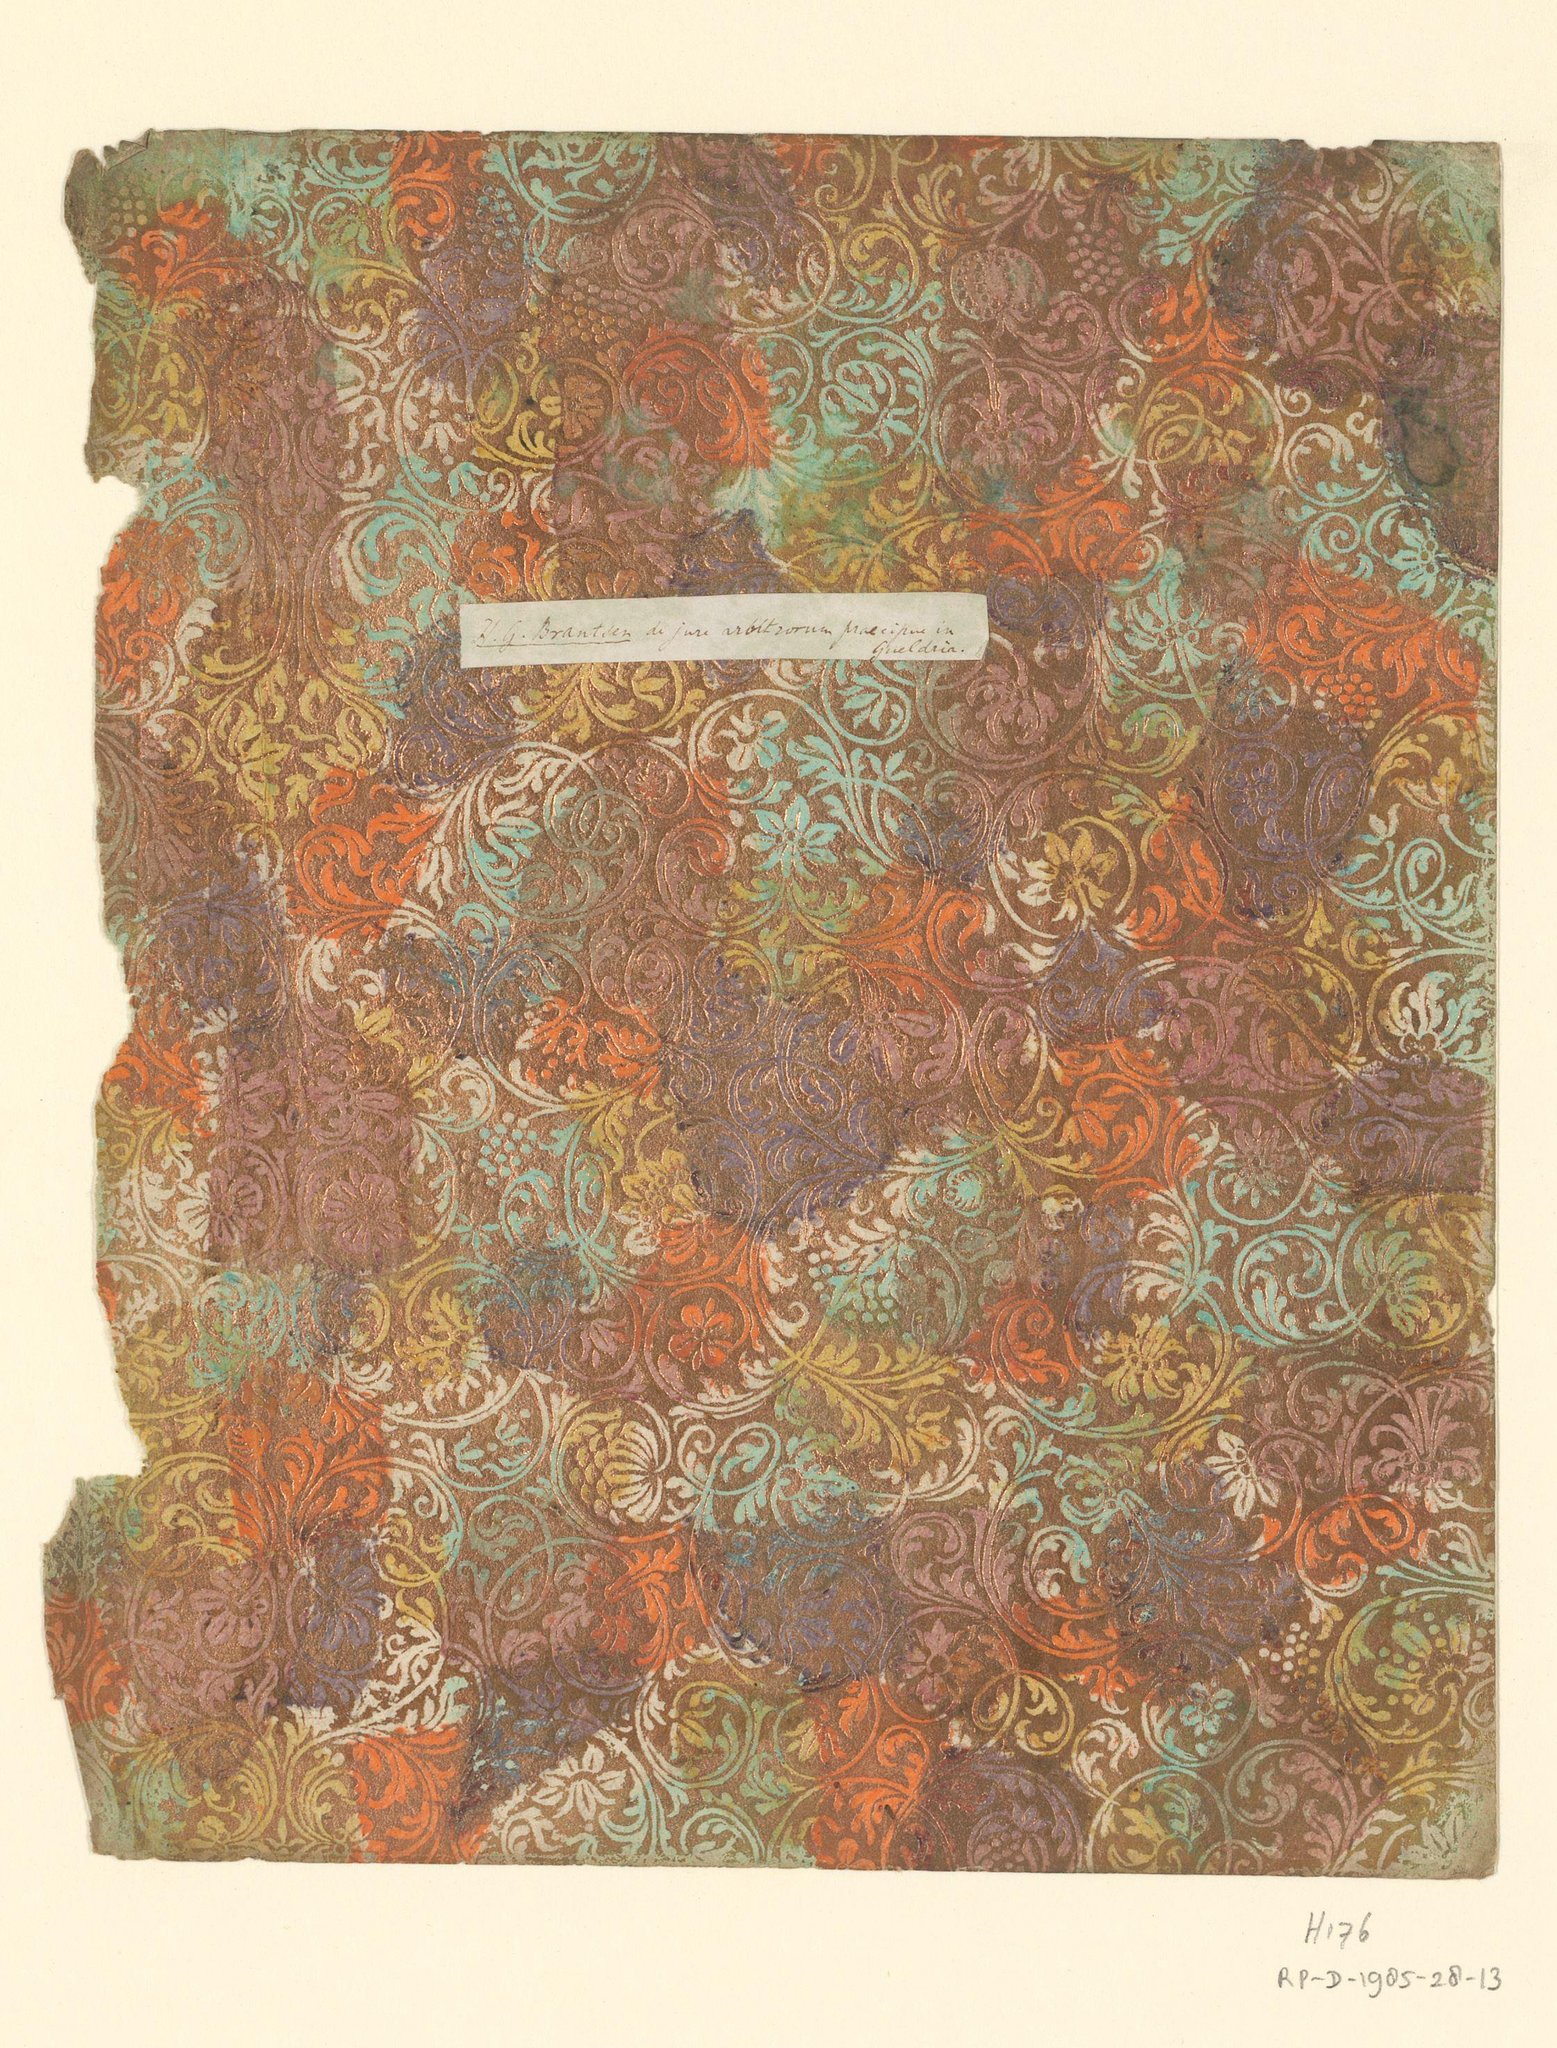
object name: wrapper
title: Blad met ranken met bloemen en vruchten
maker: johann wilhelm meyer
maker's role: papiermaker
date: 1740-1780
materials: gold leaf, paint, paper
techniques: relief print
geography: augsburg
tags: ornament derived from plant forms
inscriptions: collector's mark: Lugt 2760, collector's mark: Lugt 2228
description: Blad met ranken met bloemen en vruchten. Met etiket met opschrift: 'H.G. Brantsen / de jure ... Gueldria'. Helft van een omslag.